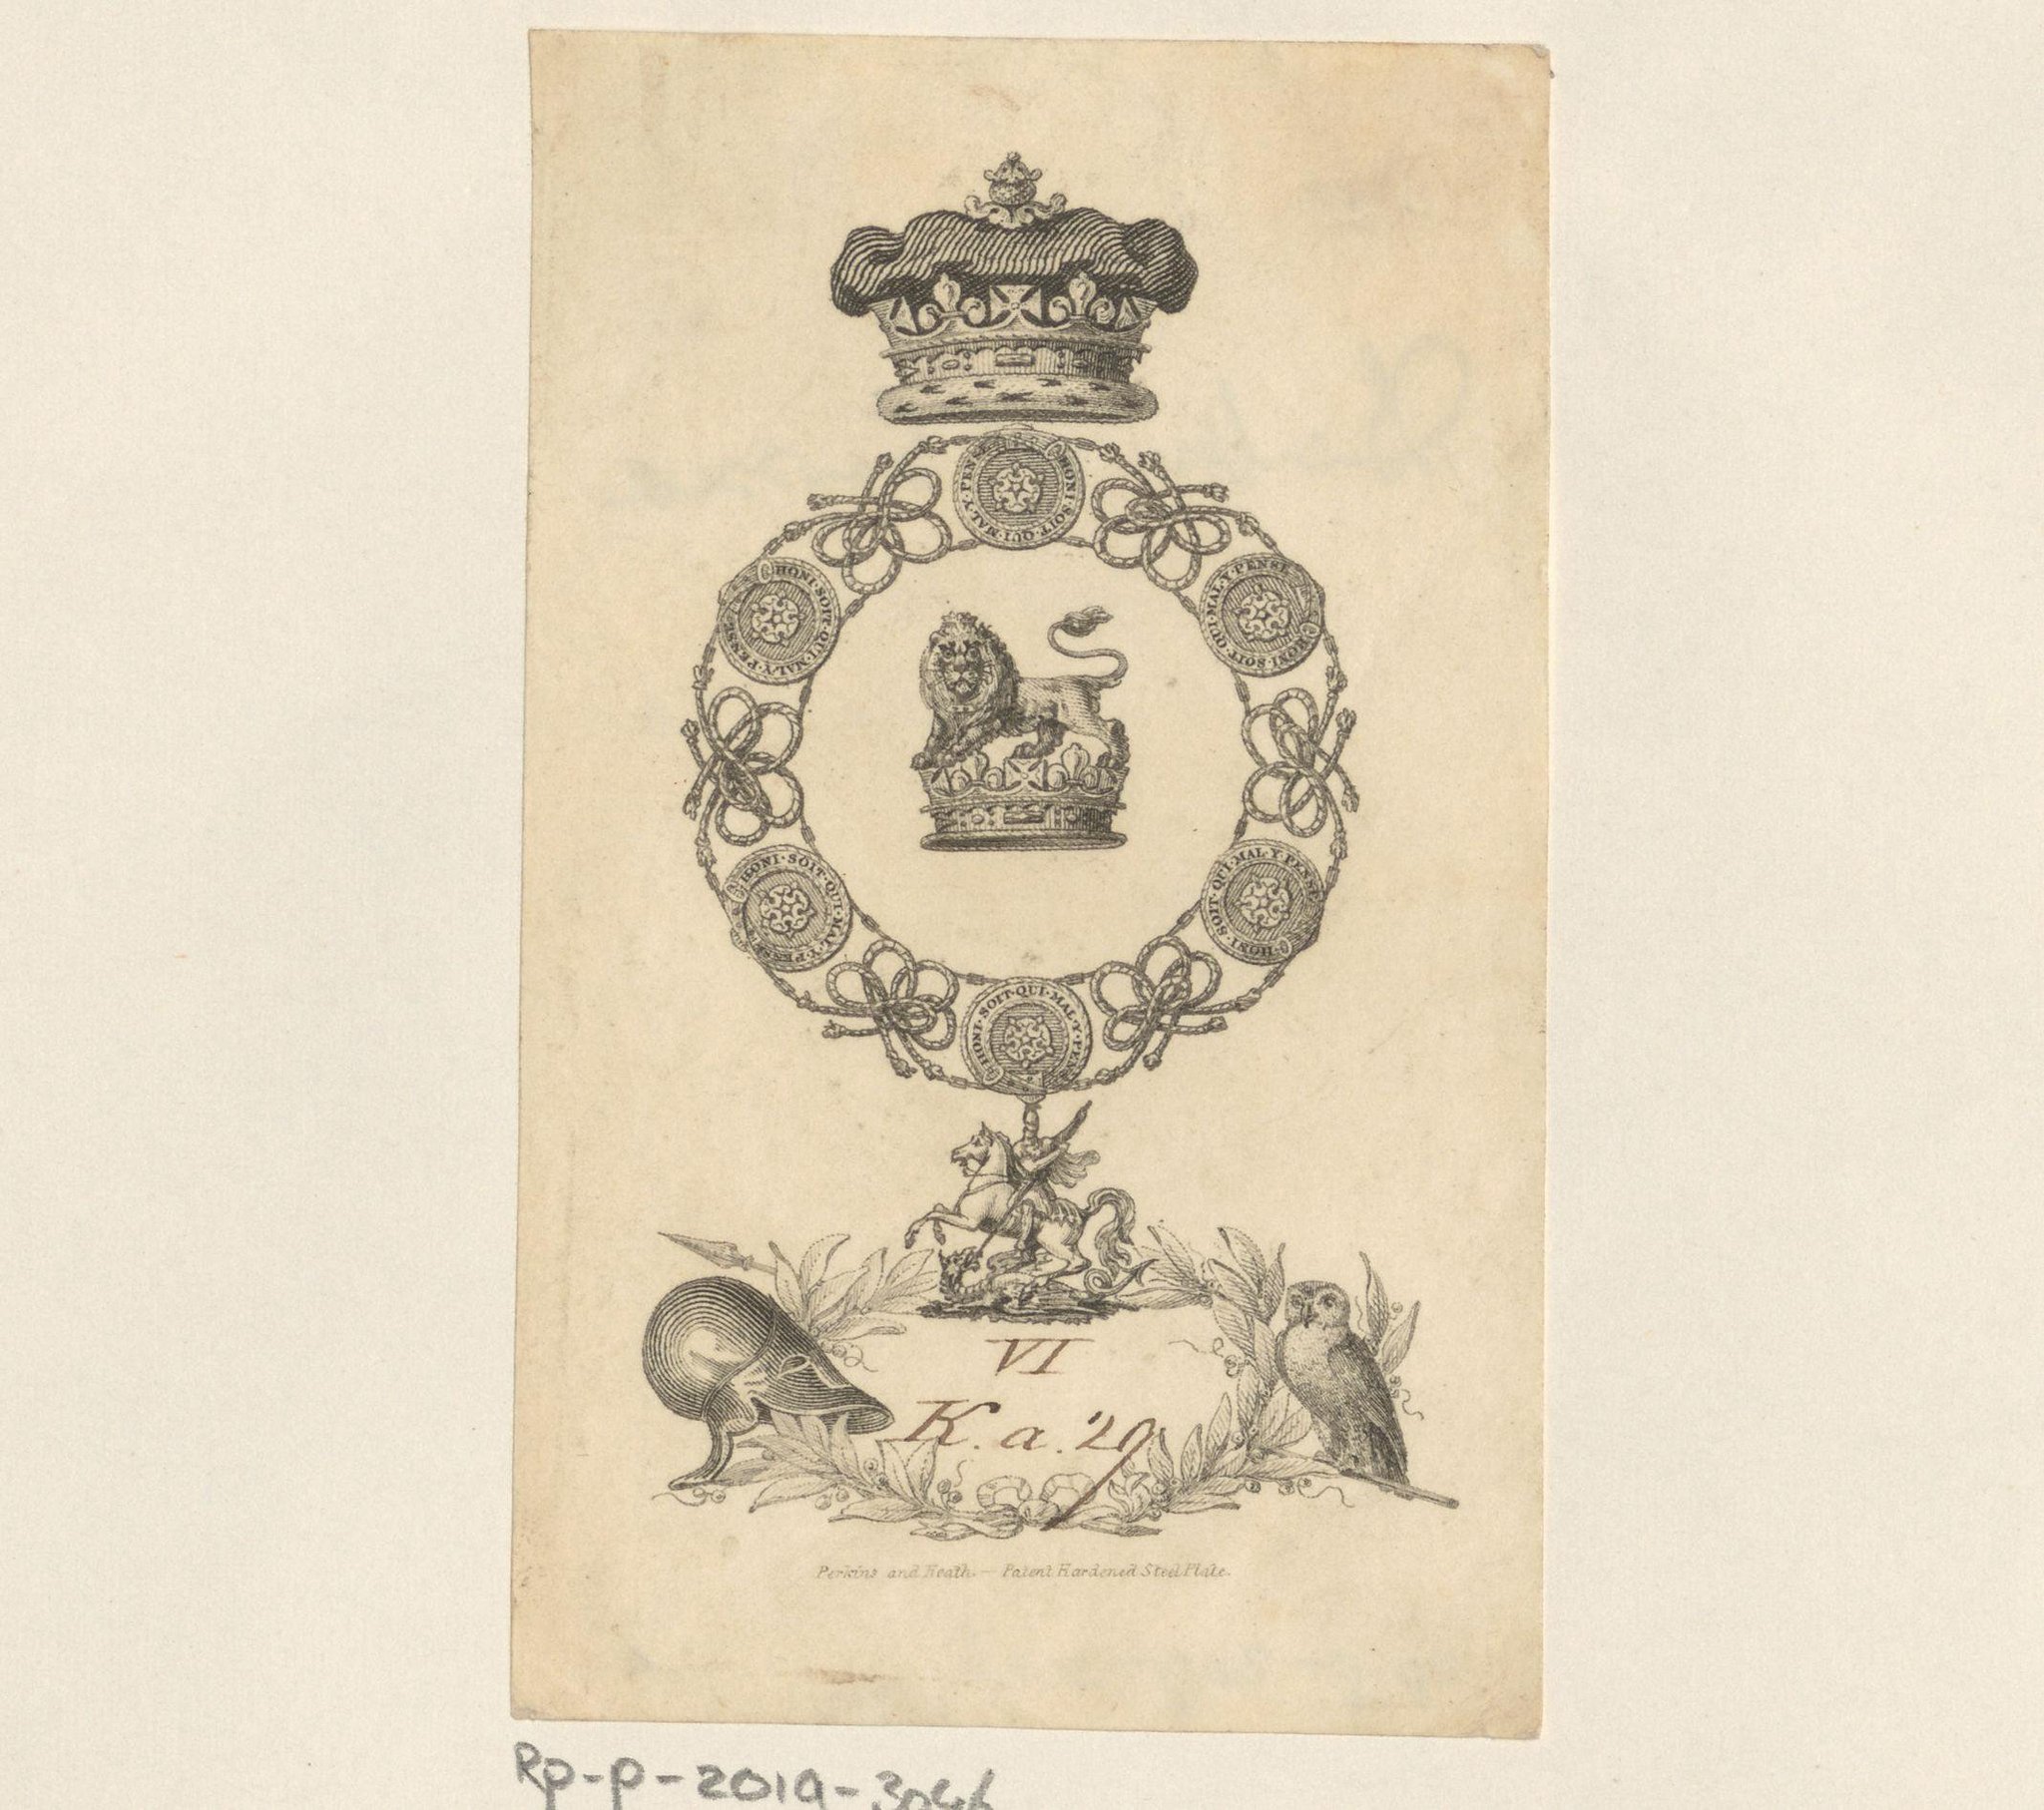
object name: bookplate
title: Ex libris van onbekend, mogelijk van de hertog van Sussex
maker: Anonymous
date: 1822-1829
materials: paper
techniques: engraving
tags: ruler, sovereign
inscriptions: inscription: ‘VI K.a. 29’